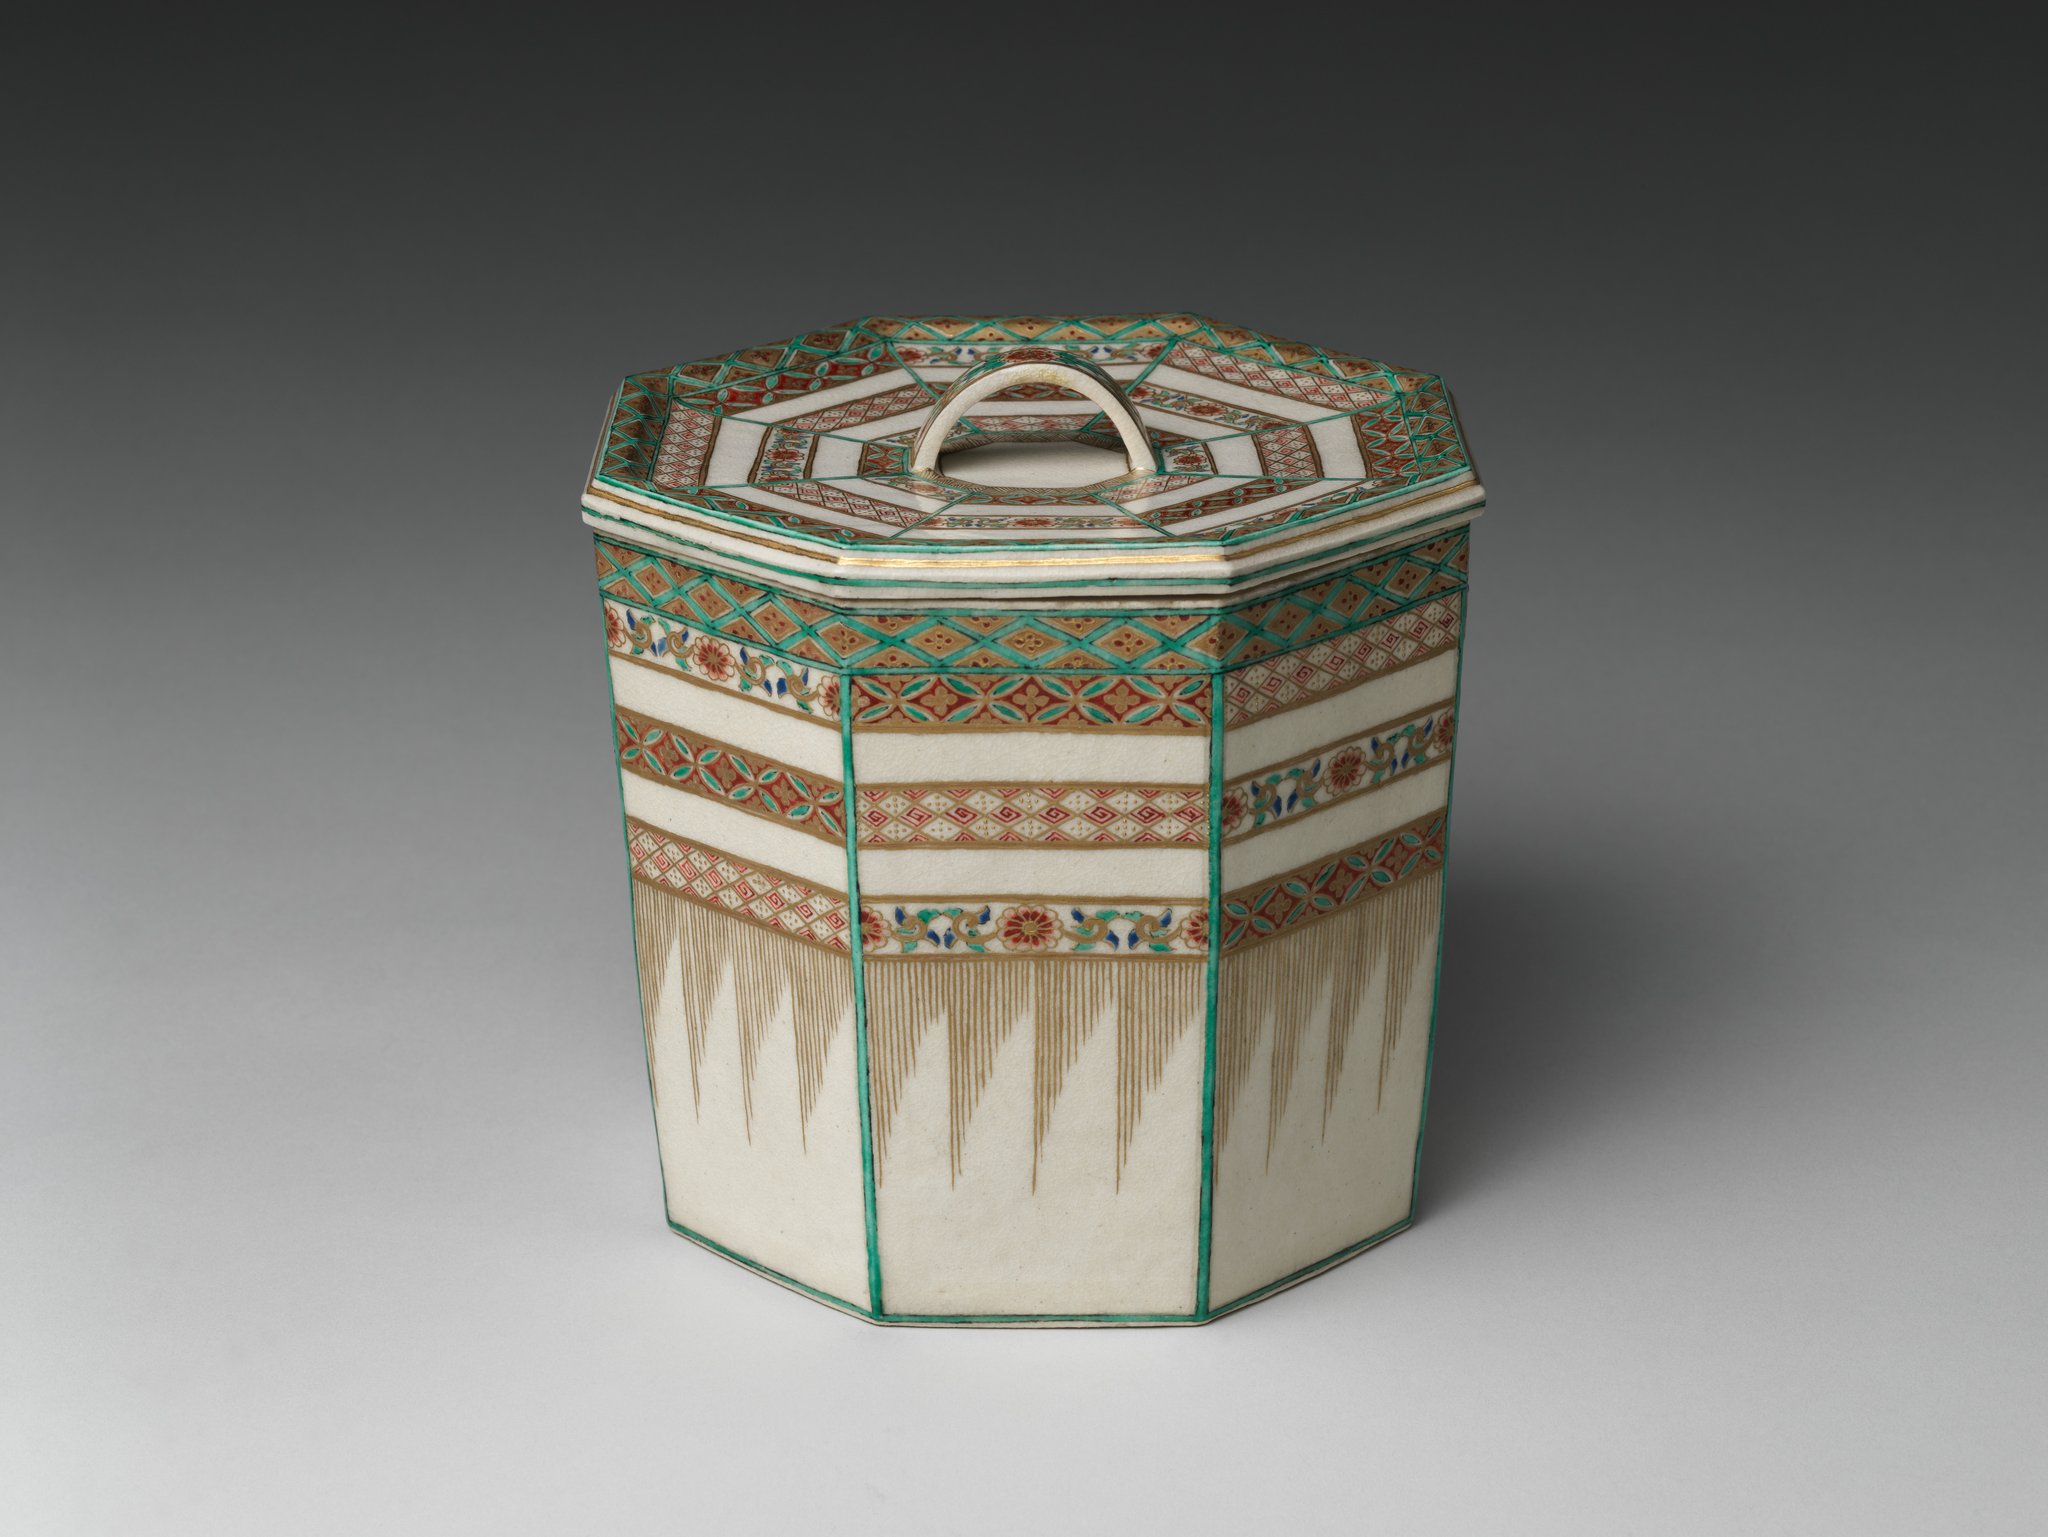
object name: covered water vessel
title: Water Jar (Mizusashi) with Geometric Patterns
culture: japanese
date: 1834-1866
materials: enamel, glaze, gold, stoneware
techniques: polychrome